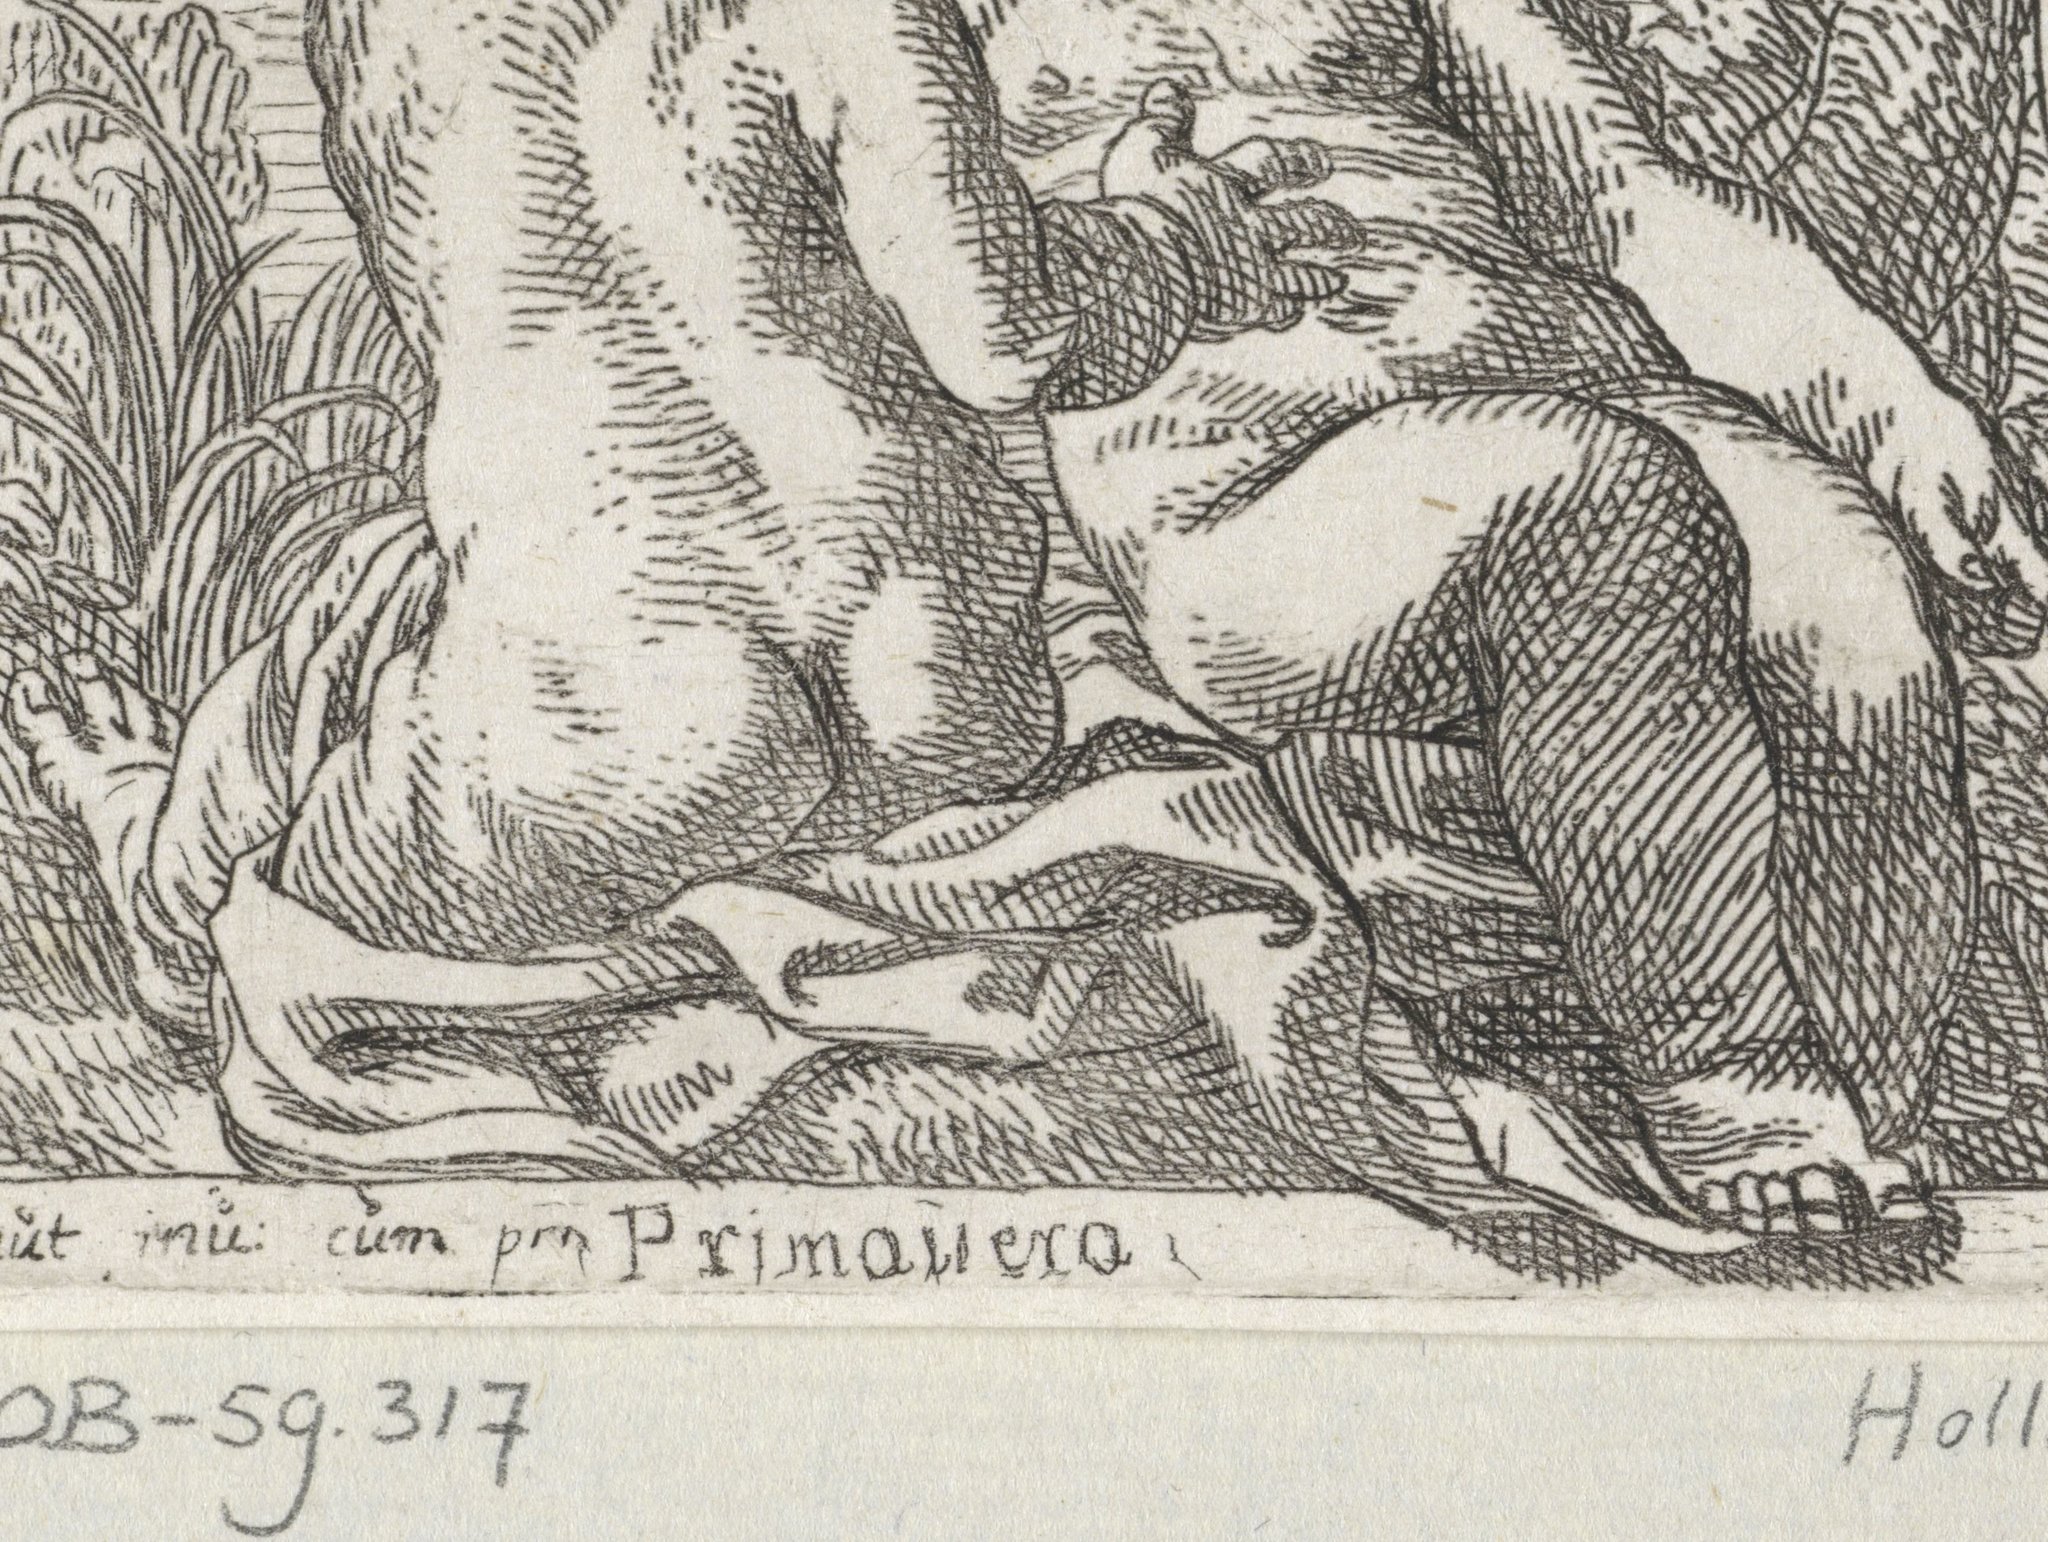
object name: print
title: Primavera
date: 1618-1655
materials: paper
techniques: etching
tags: spring, 'ver'; 'primavera' (ripa)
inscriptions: collector's mark: Lugt 240